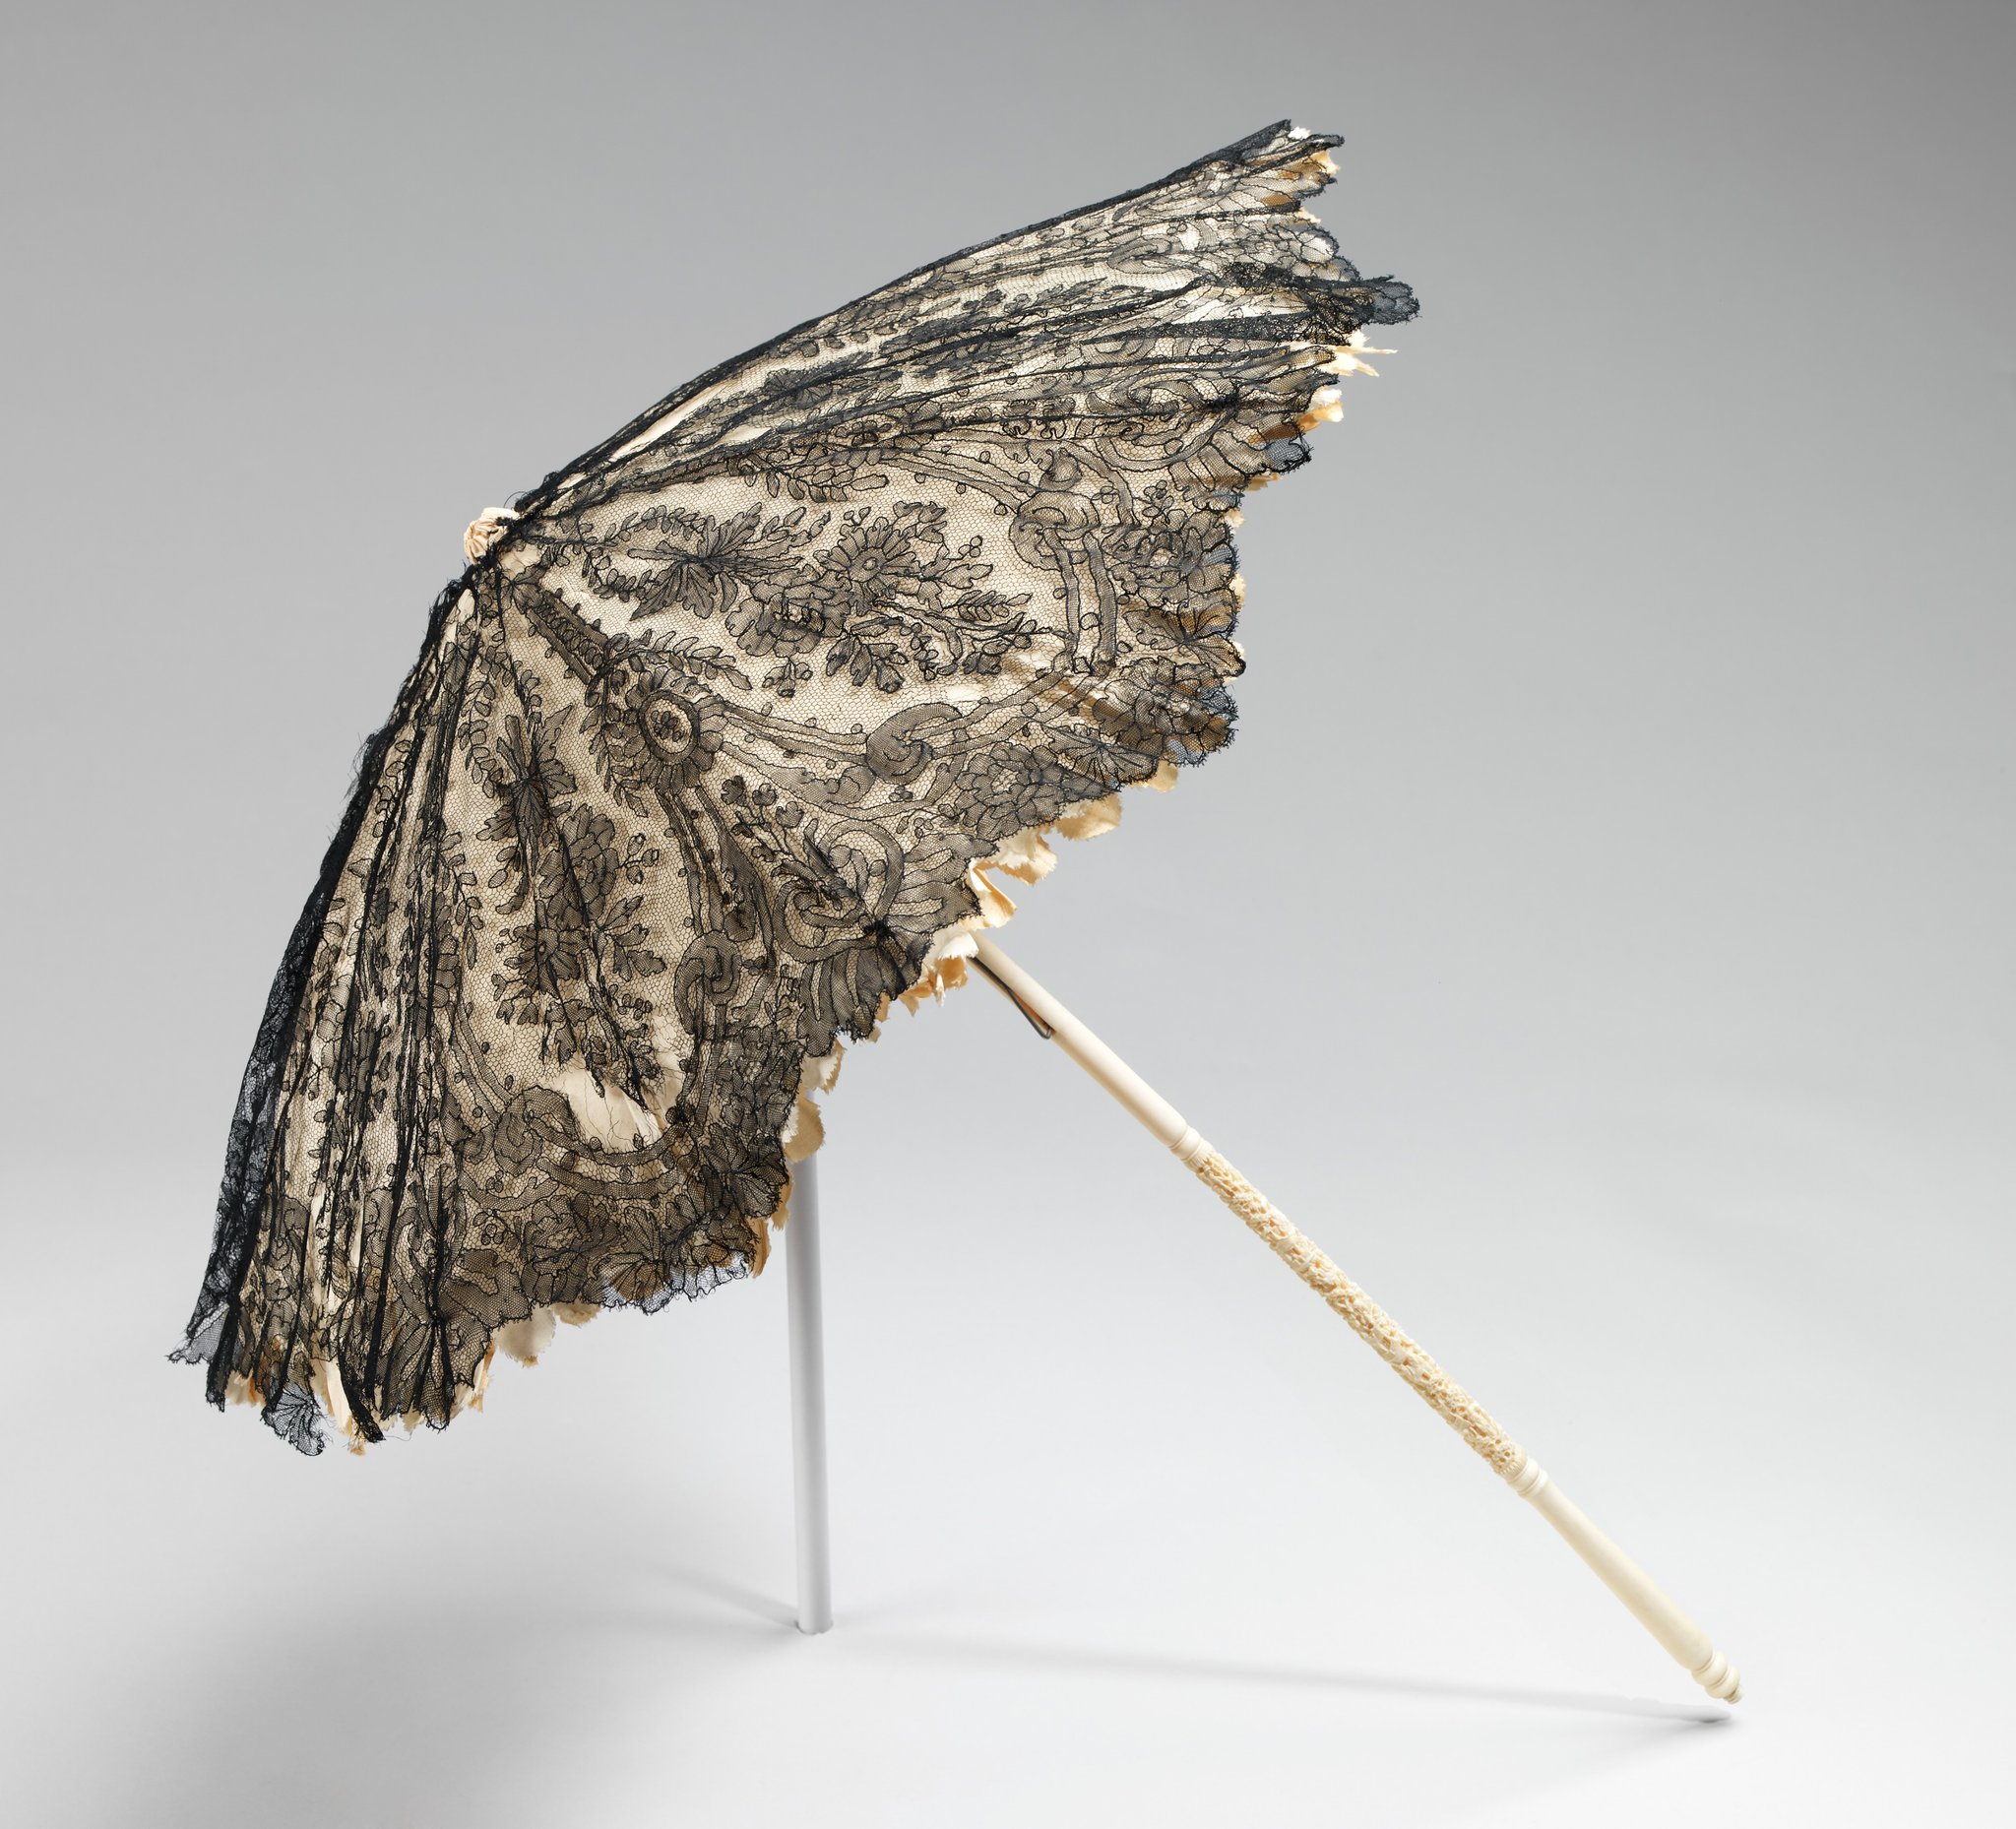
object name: parasol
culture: french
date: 1875-1880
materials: ivory, metal, silk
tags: flowers